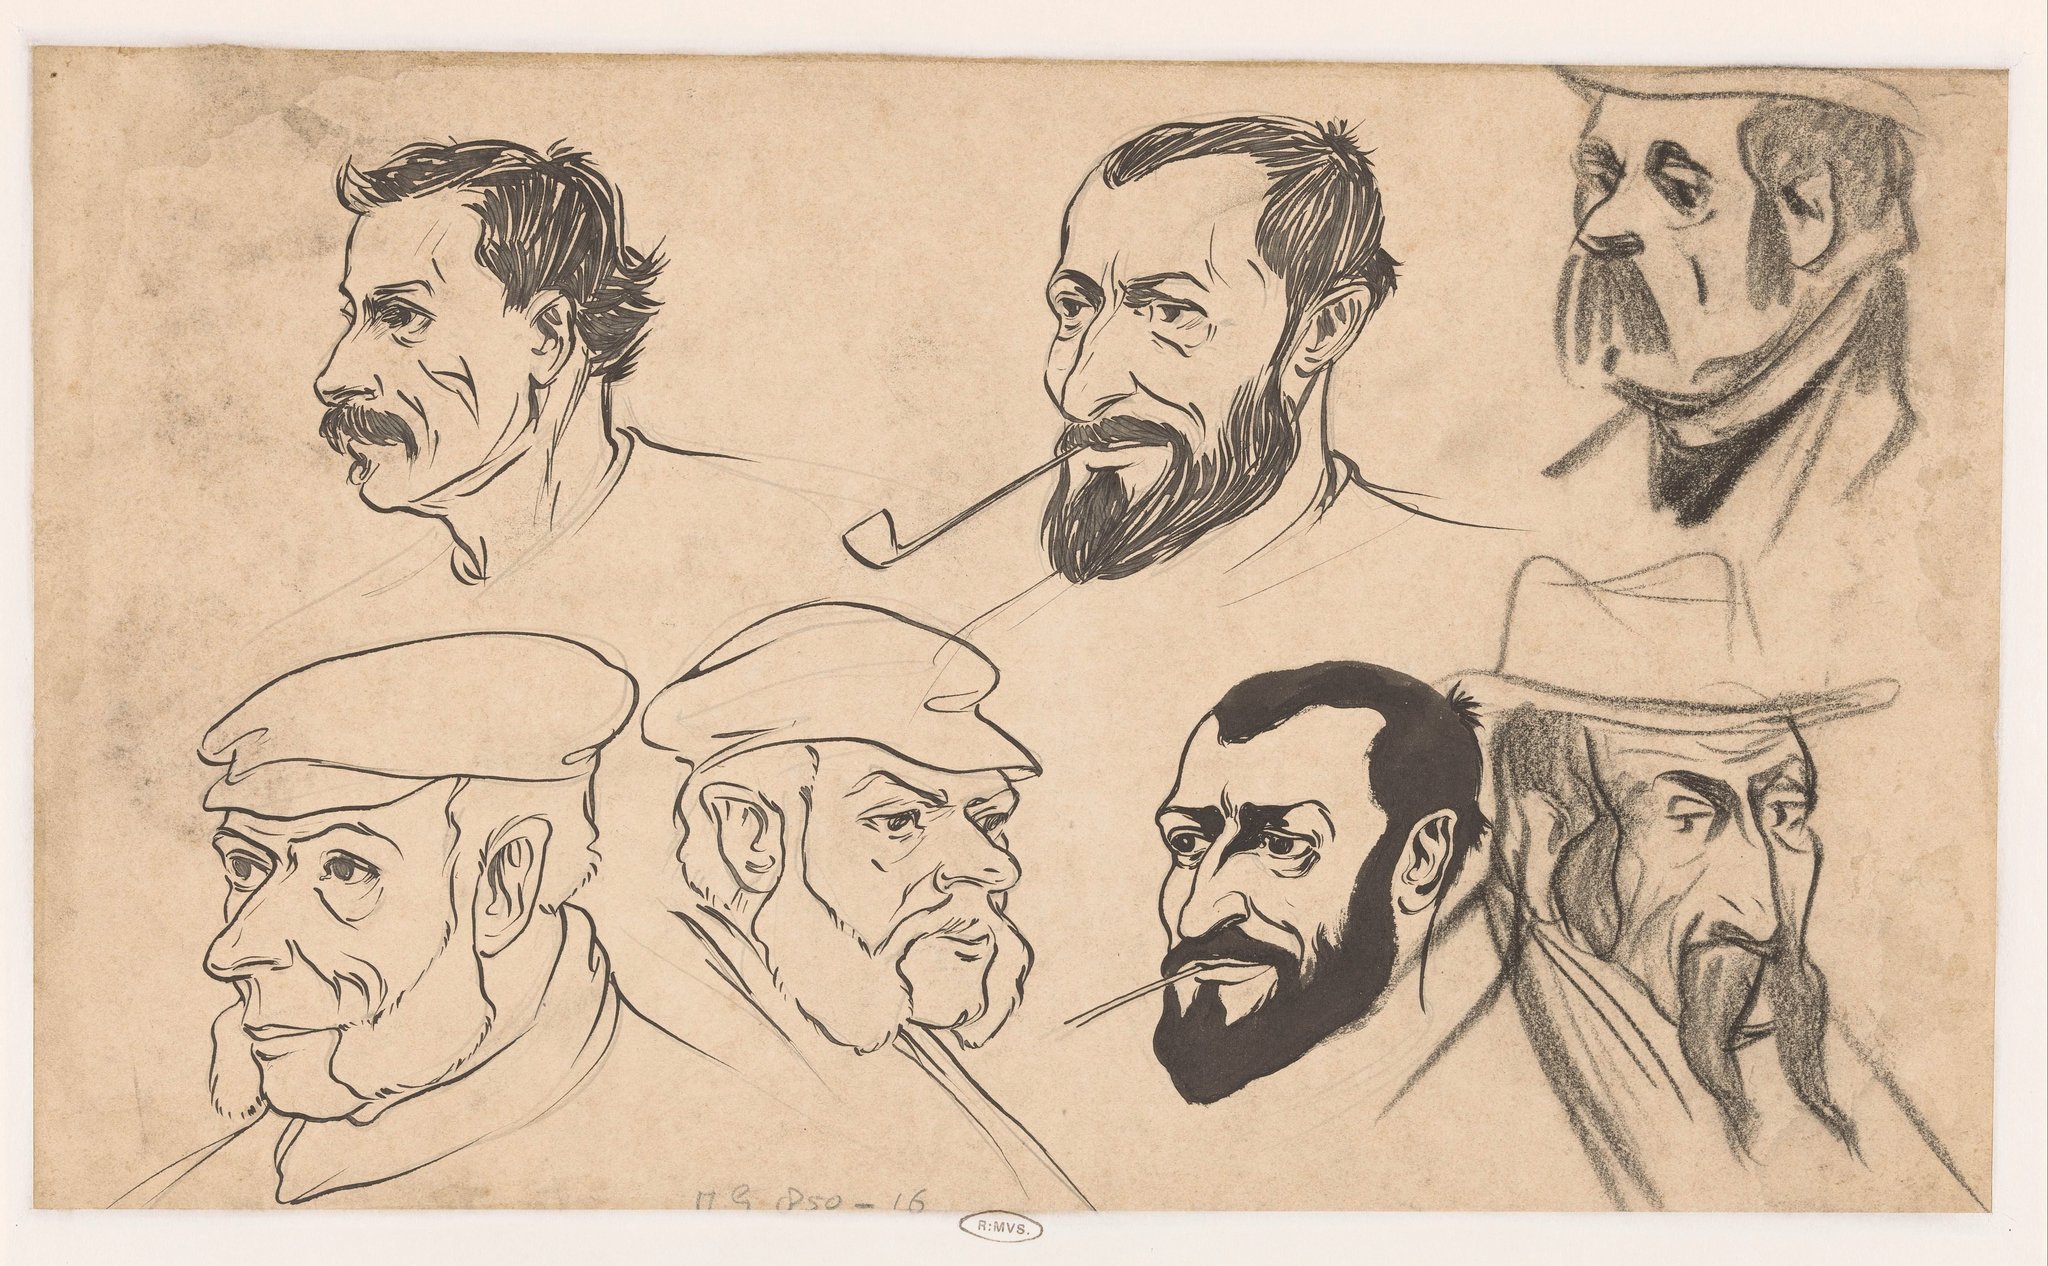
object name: drawing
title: Studieblad met koppen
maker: jan de waardt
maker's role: draughtsman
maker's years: 1871-1909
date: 1875-1900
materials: chalk, ink, paper, pencil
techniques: brush, pen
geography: netherlands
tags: netherlands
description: Studieblad met zeven studies van mannenhoofden.